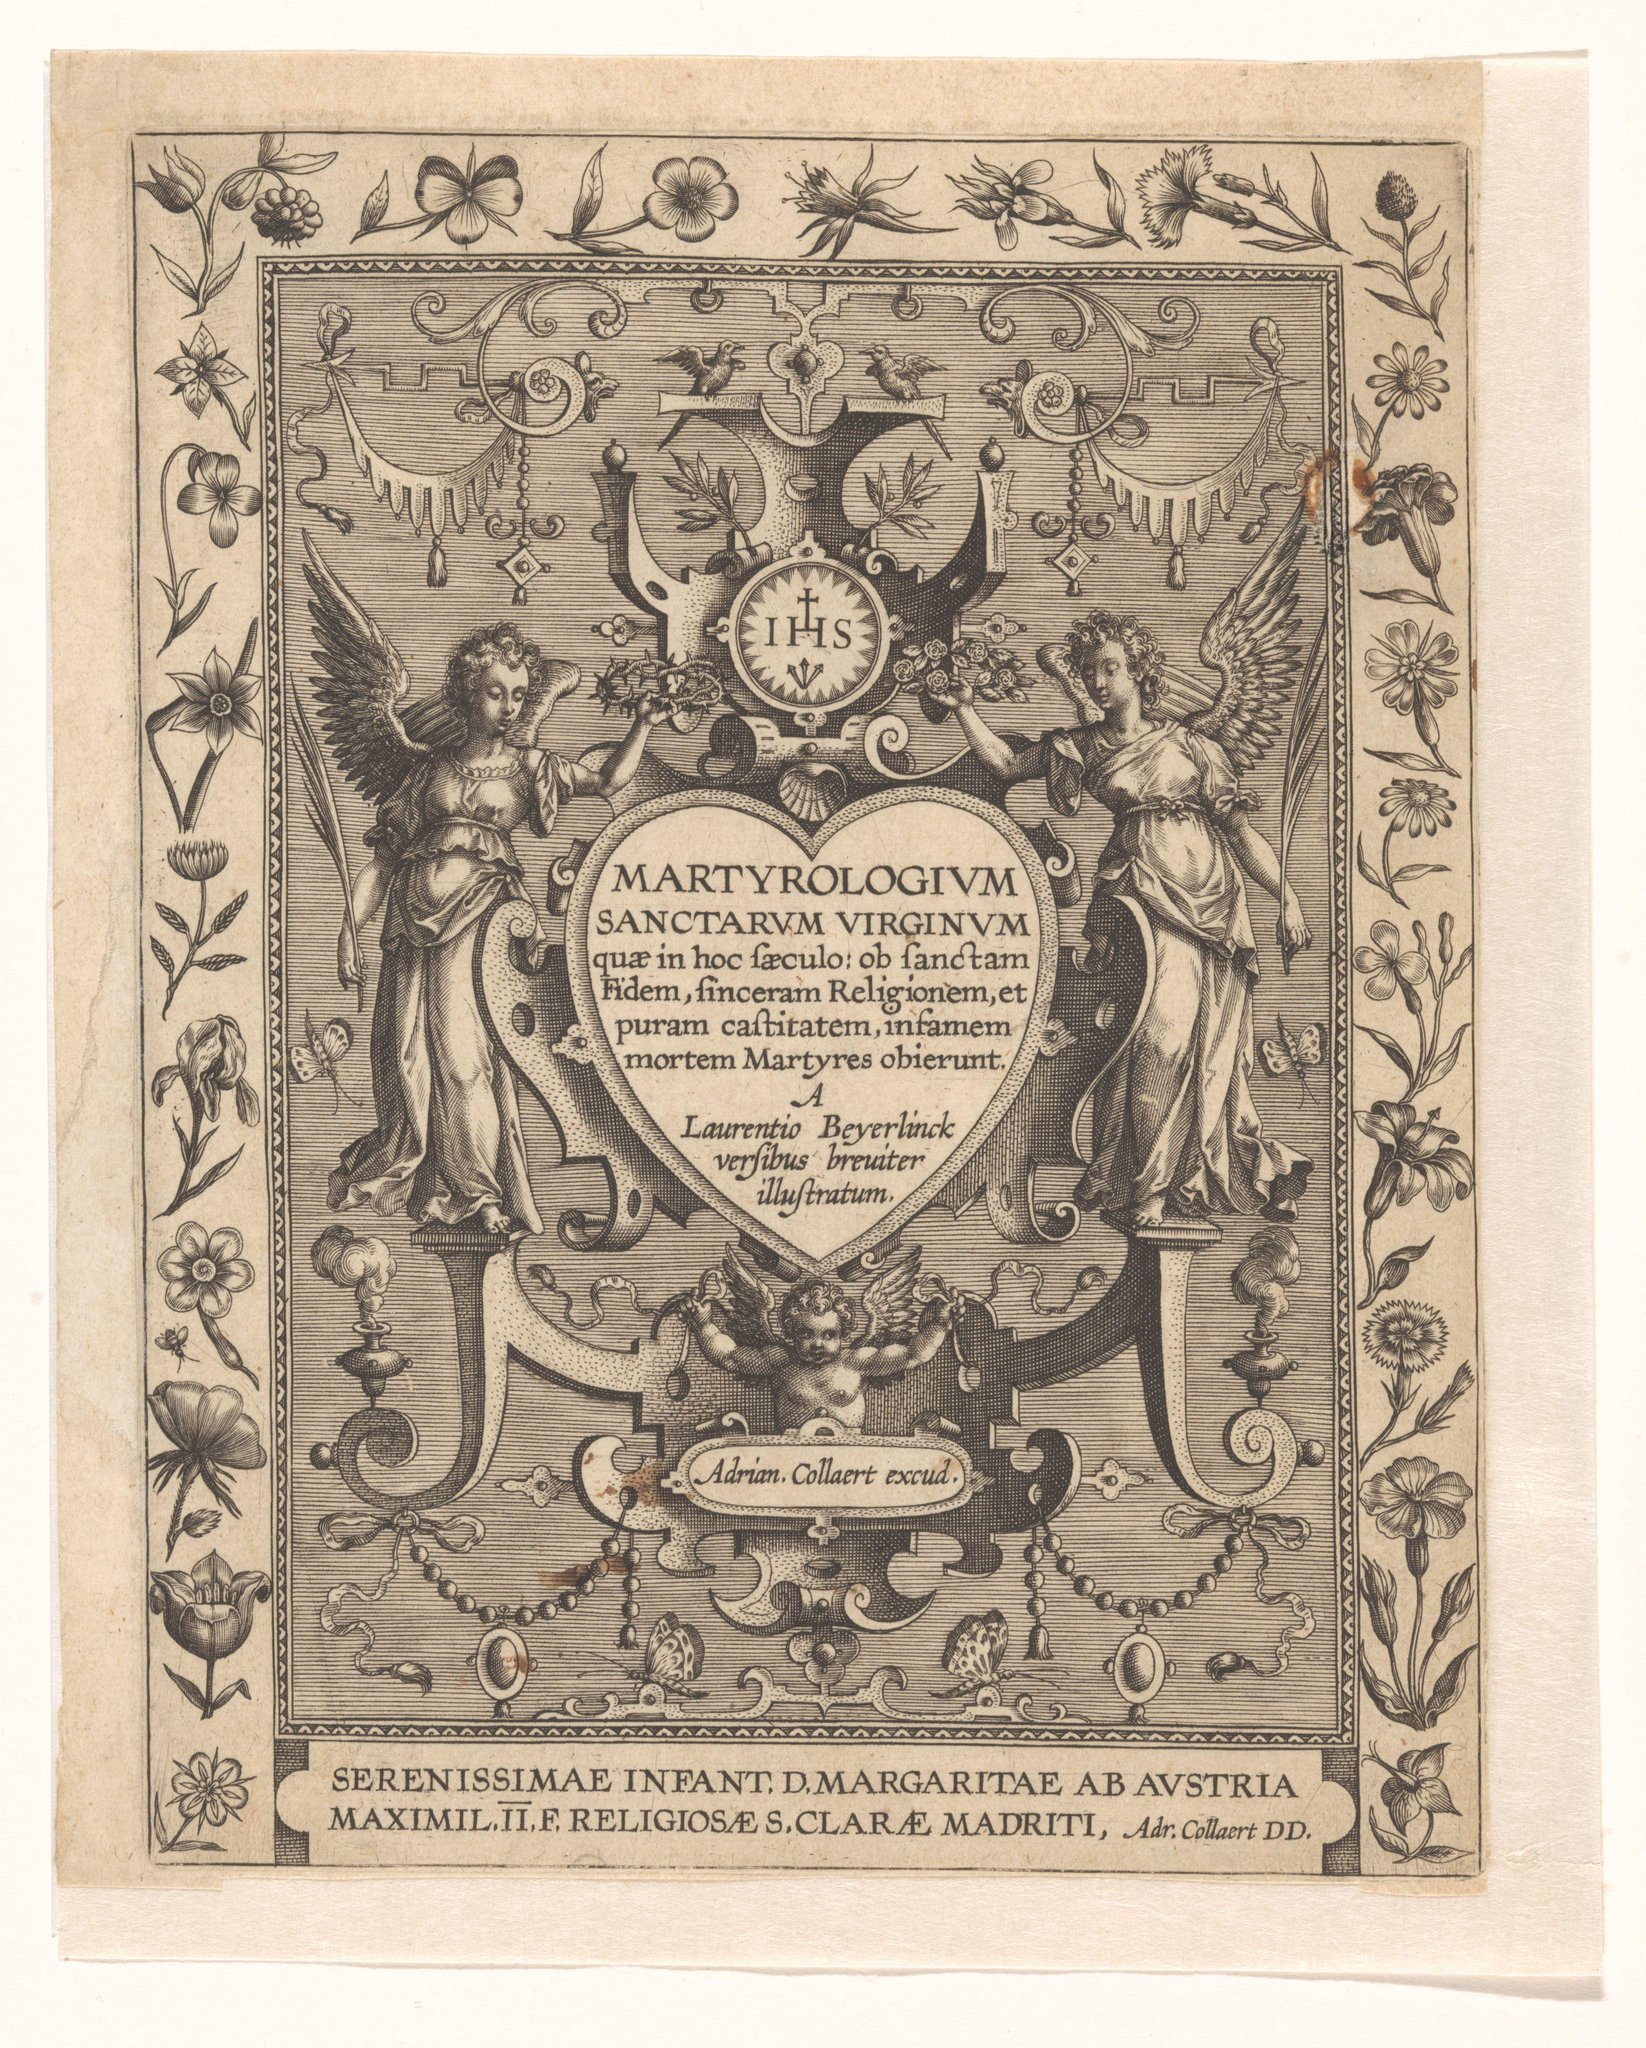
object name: titelprent, frontispice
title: Titelprent van een serie van 24 voorstellingen van vrouwelijke martelaren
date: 1590-1610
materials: paper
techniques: engraving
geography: antwerp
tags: flowers, angels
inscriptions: collector's mark: Lugt 2760, collector's mark: Lugt 3751, collector's mark: Lugt 2228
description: Titel in hartvormig cartouche geflankeerd door twee engelen. Titelprent van een serie van 24 voorstellingen van vrouwelijke martelaren (martyrologium). De voorstellingen zijn voorzien van randen met bloemen en dieren.